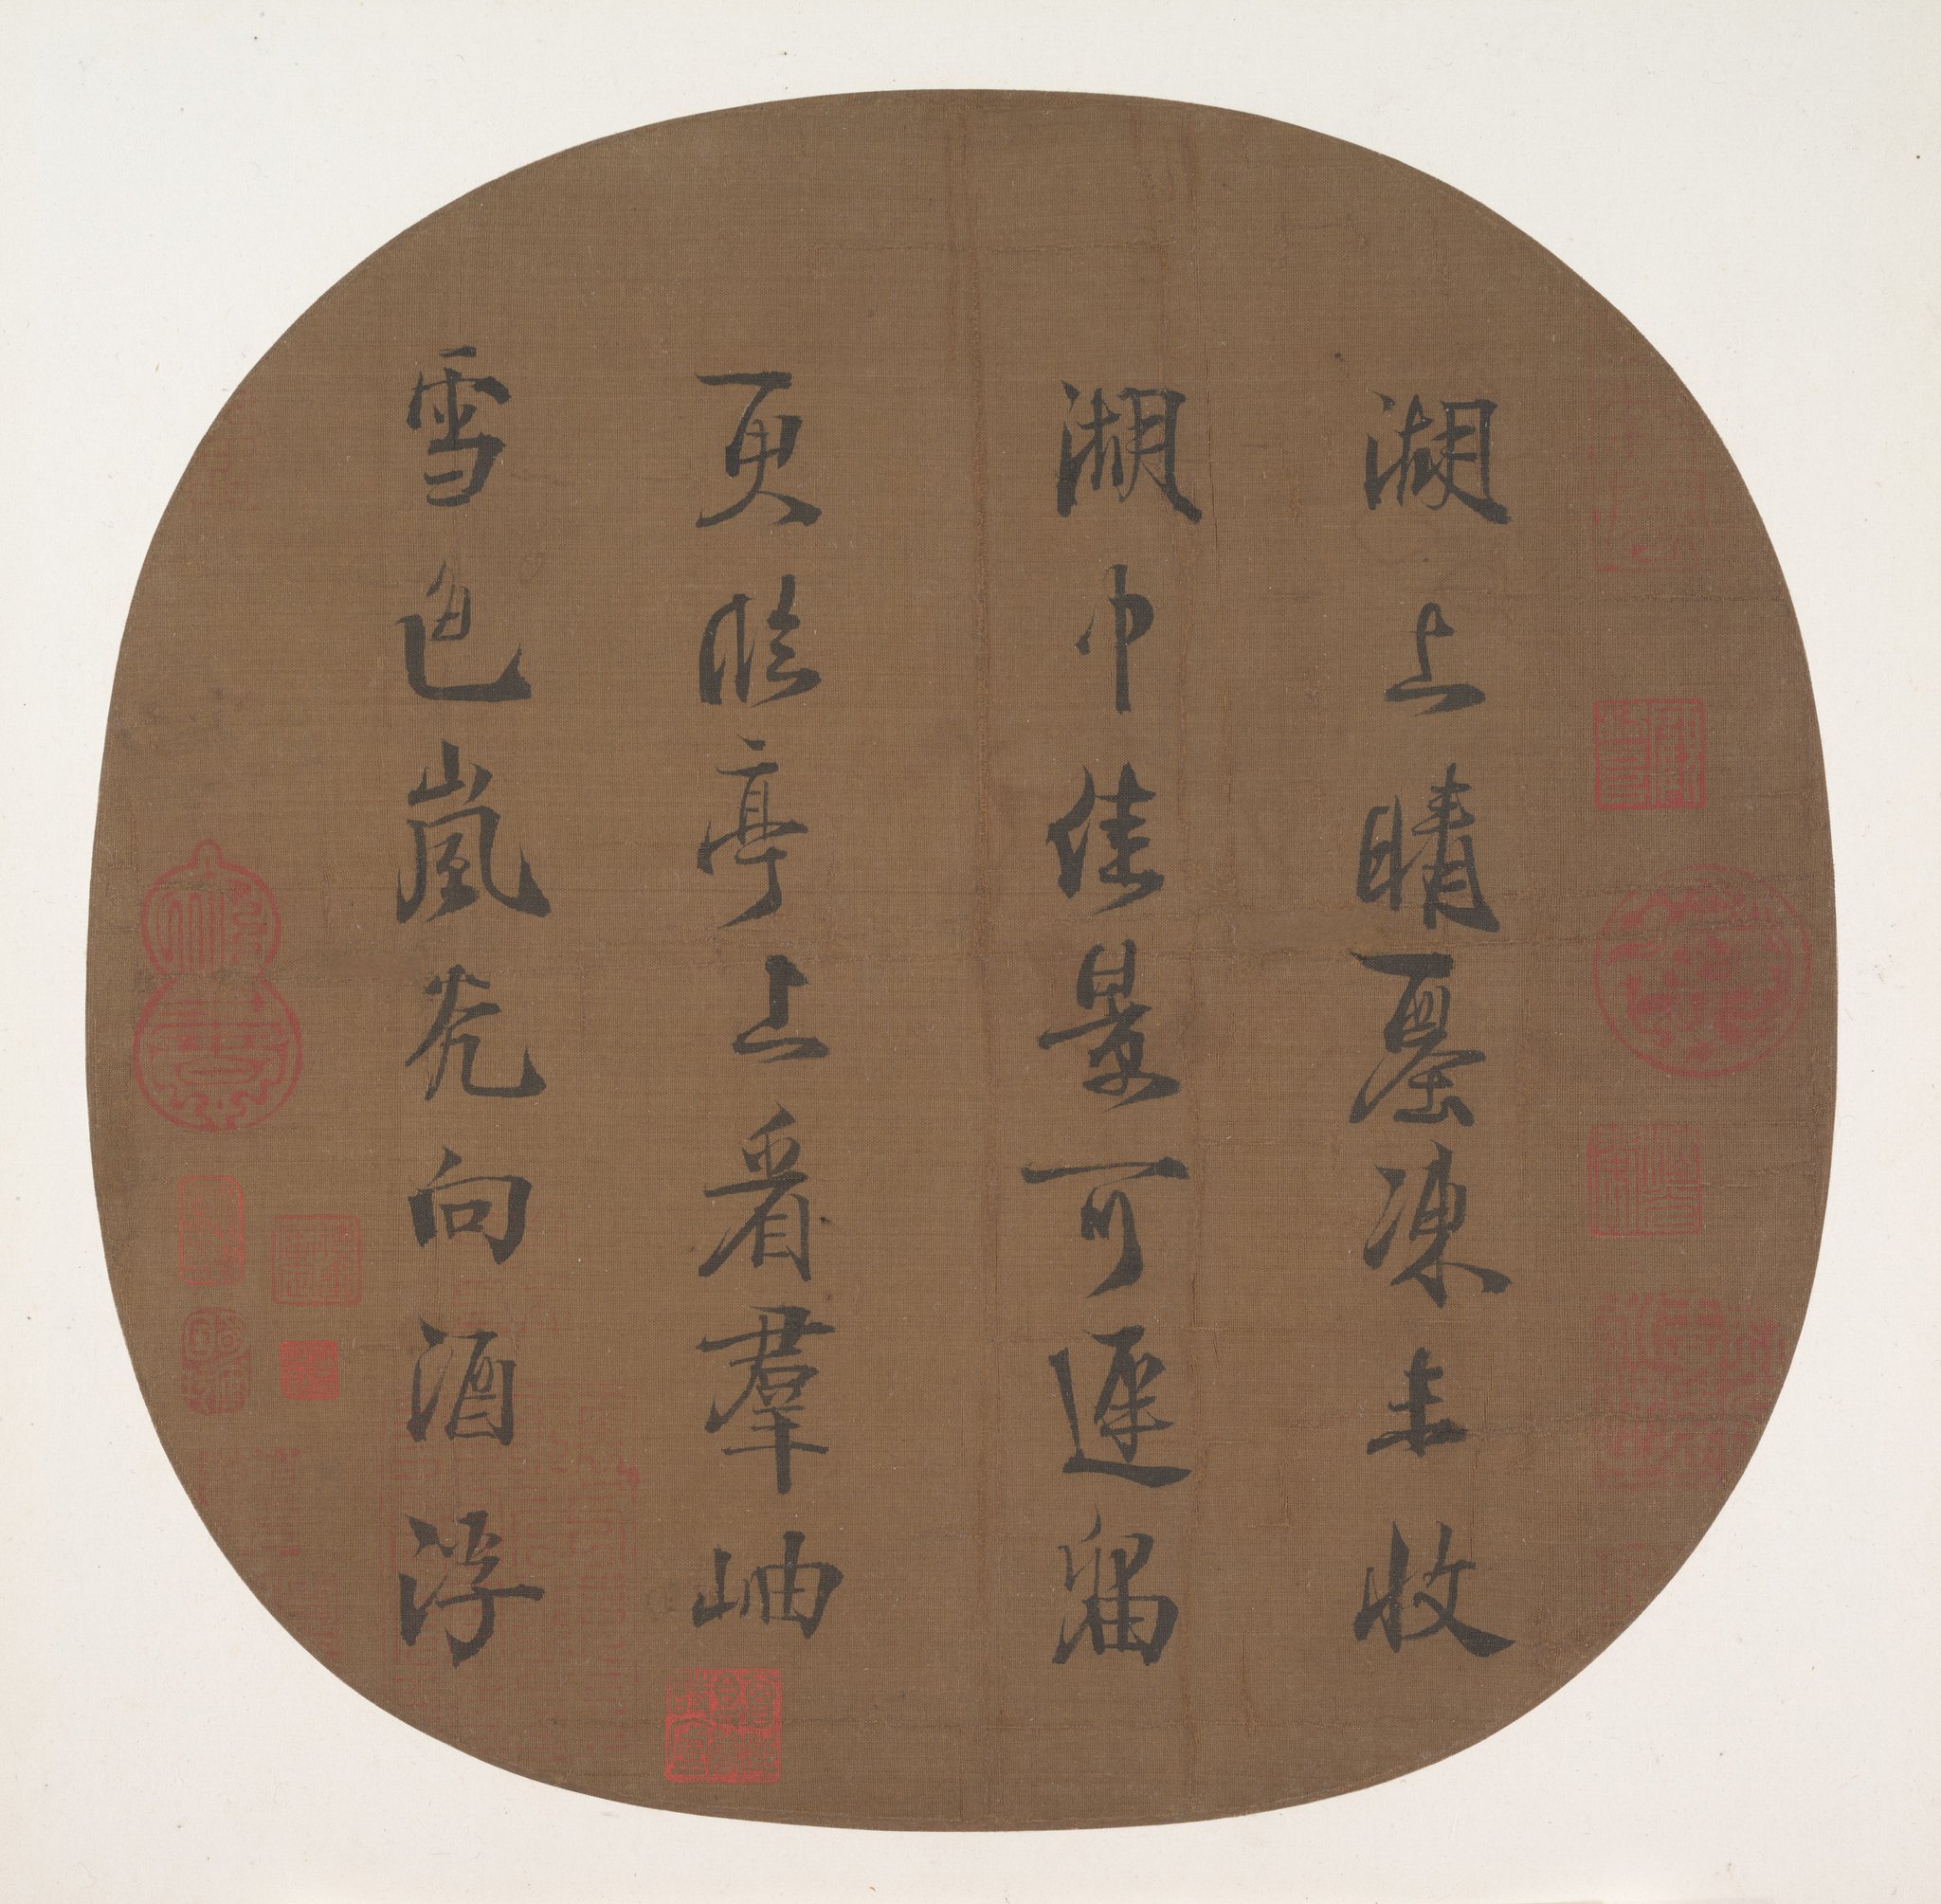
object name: fan mounted a an album leaf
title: Quatrain on Snow-covered West Lake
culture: chinese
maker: emperor lizong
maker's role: artist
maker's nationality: chinese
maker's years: 1205-1264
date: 1250-1260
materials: ink, silk